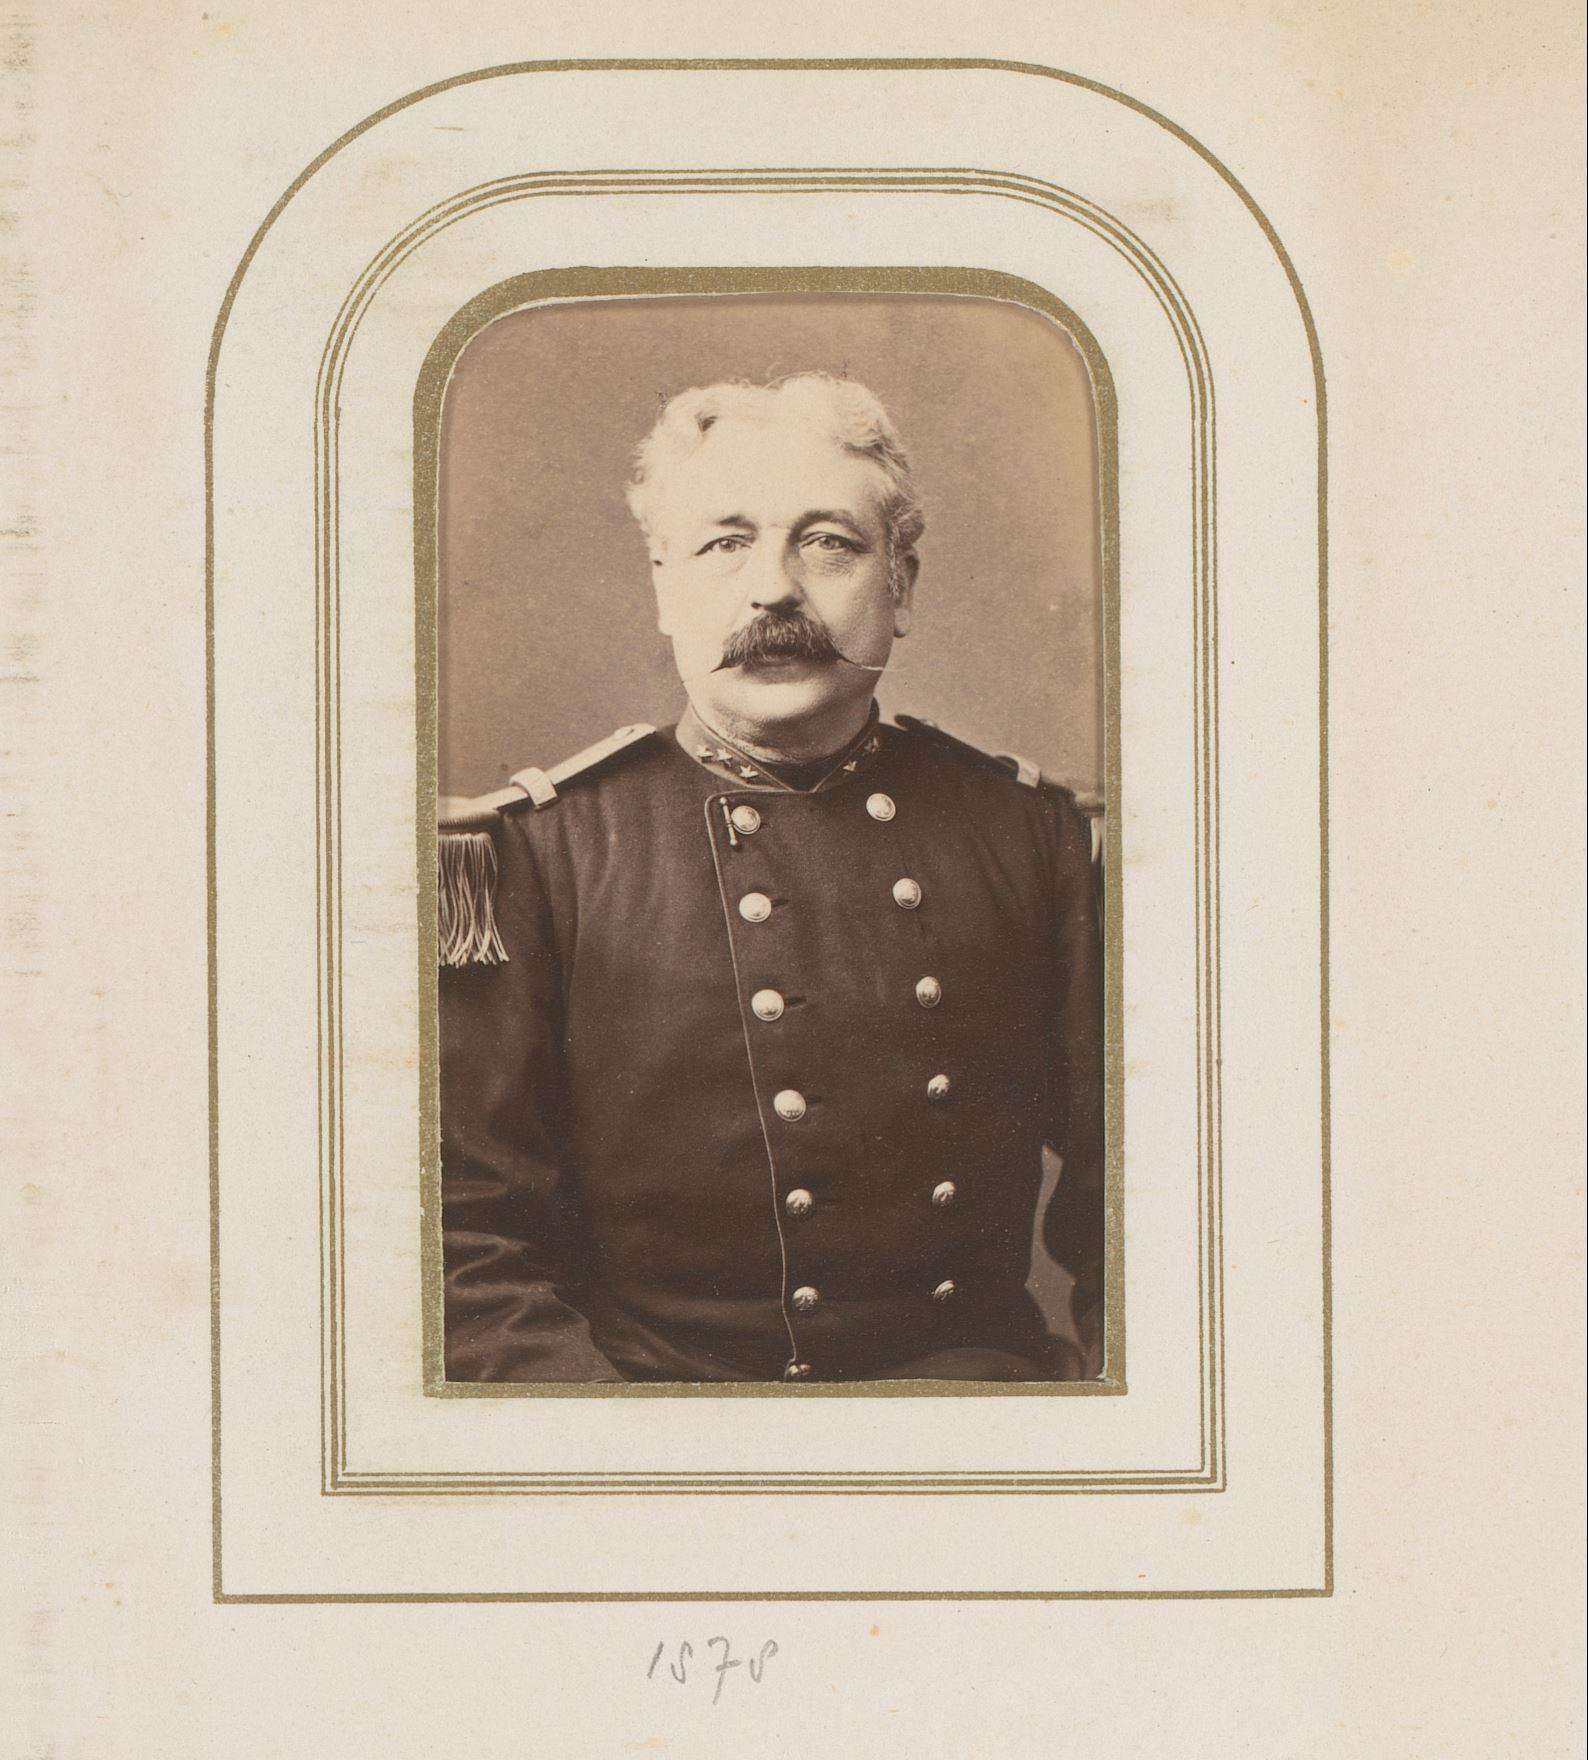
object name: photograph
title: Portret van een man met snor in uniform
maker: walter damry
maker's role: fotograaf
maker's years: 1833-1890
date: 1878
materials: cardboard, photographic support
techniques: albumen print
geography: brussels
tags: moustache, historical persons, (military) uniforms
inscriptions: inscription: ‘Walter Damry/ Bruxelles/ Rue Neuve/ Entrée Rue du Pont Neuf, 43’, annotation: ‘Souvenir de respect et de [...] à monsieur le Colonel Lemoine/ Mons 1er October 1874 [...]’